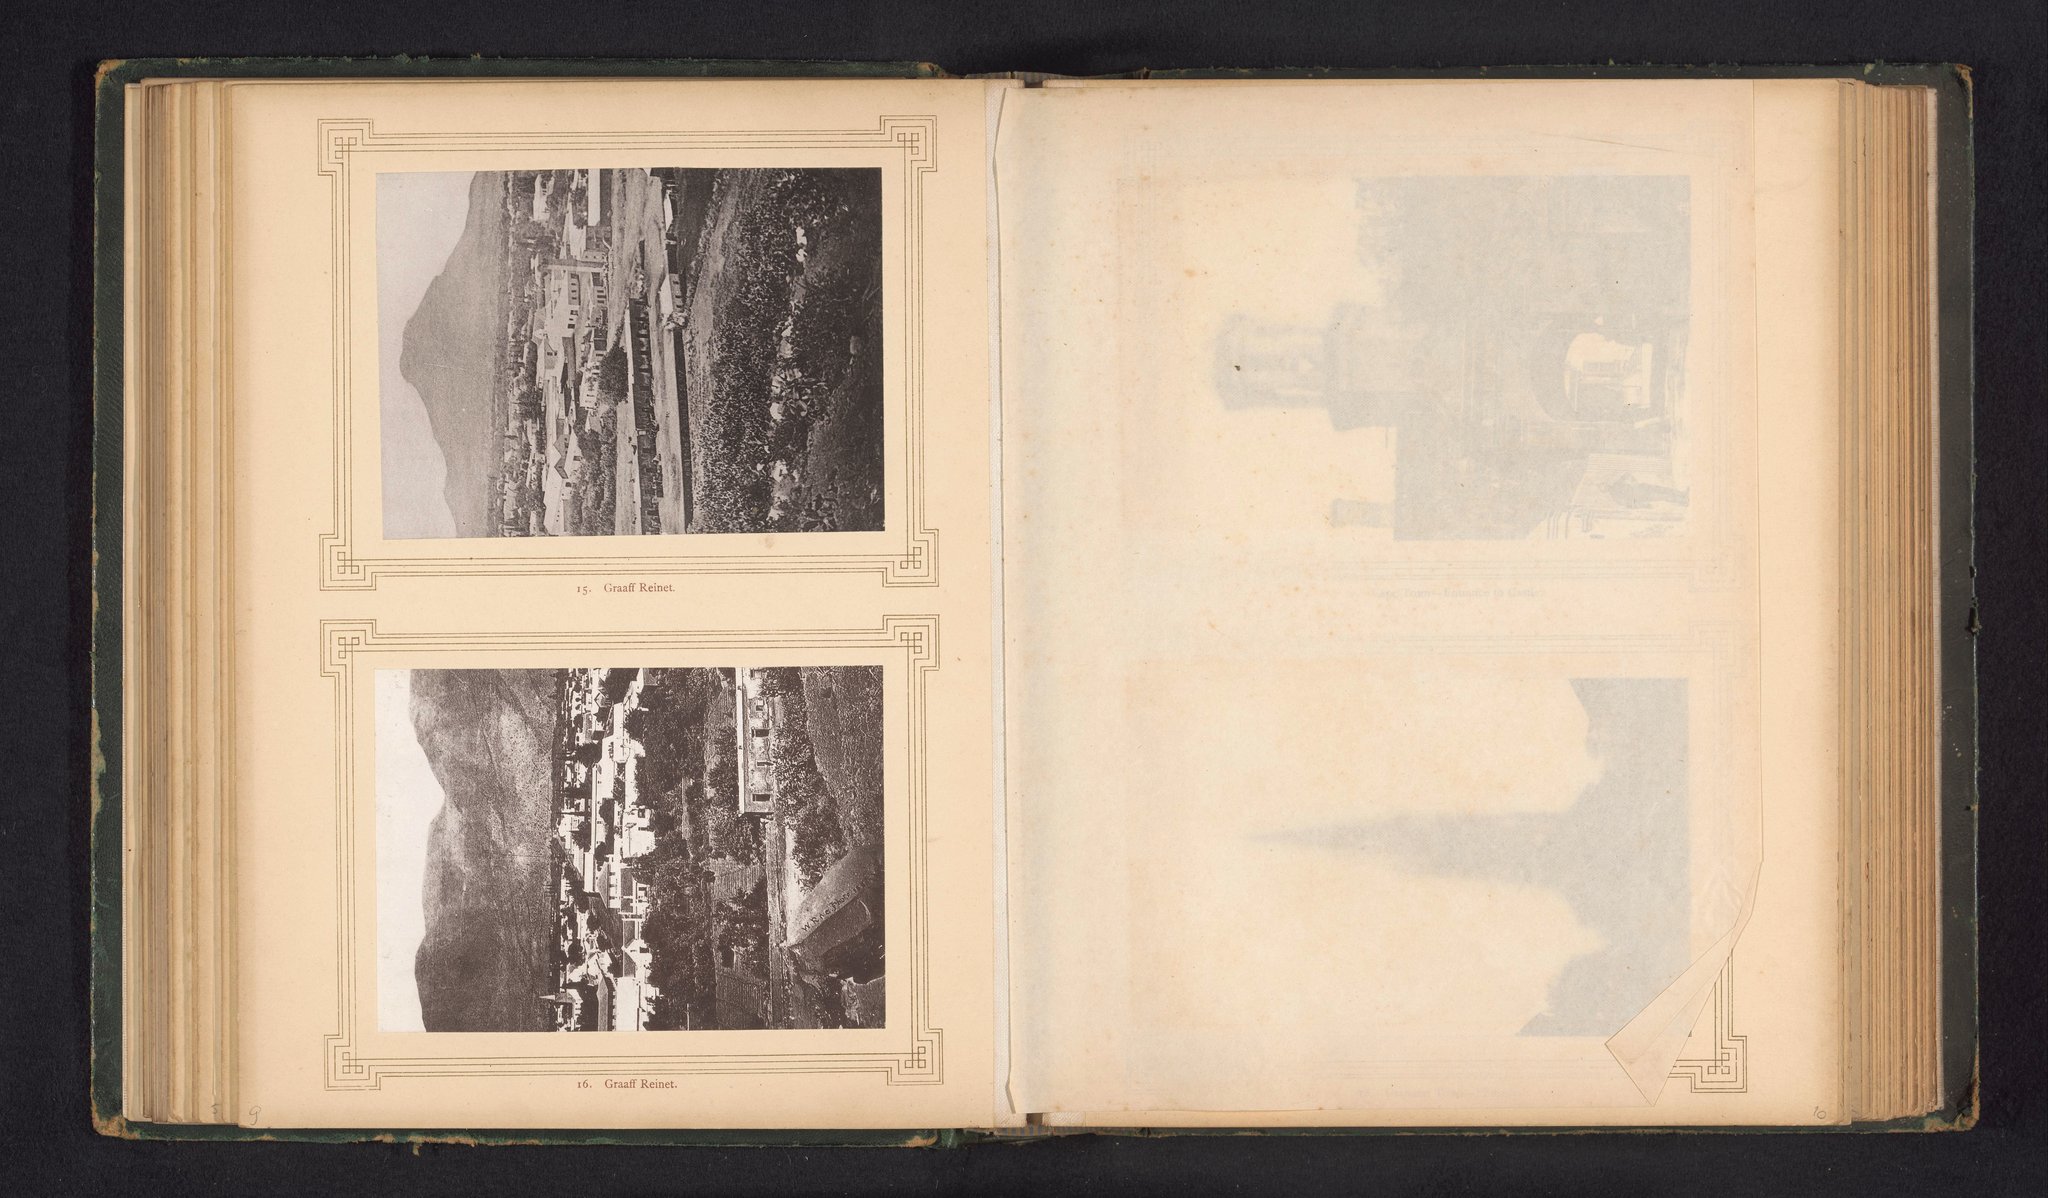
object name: page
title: Graaff Reinet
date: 1870-1880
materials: paper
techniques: photograph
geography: south africa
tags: city-view in general; 'veduta'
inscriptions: number: ‘15. 16.’, inscription: ‘SA’